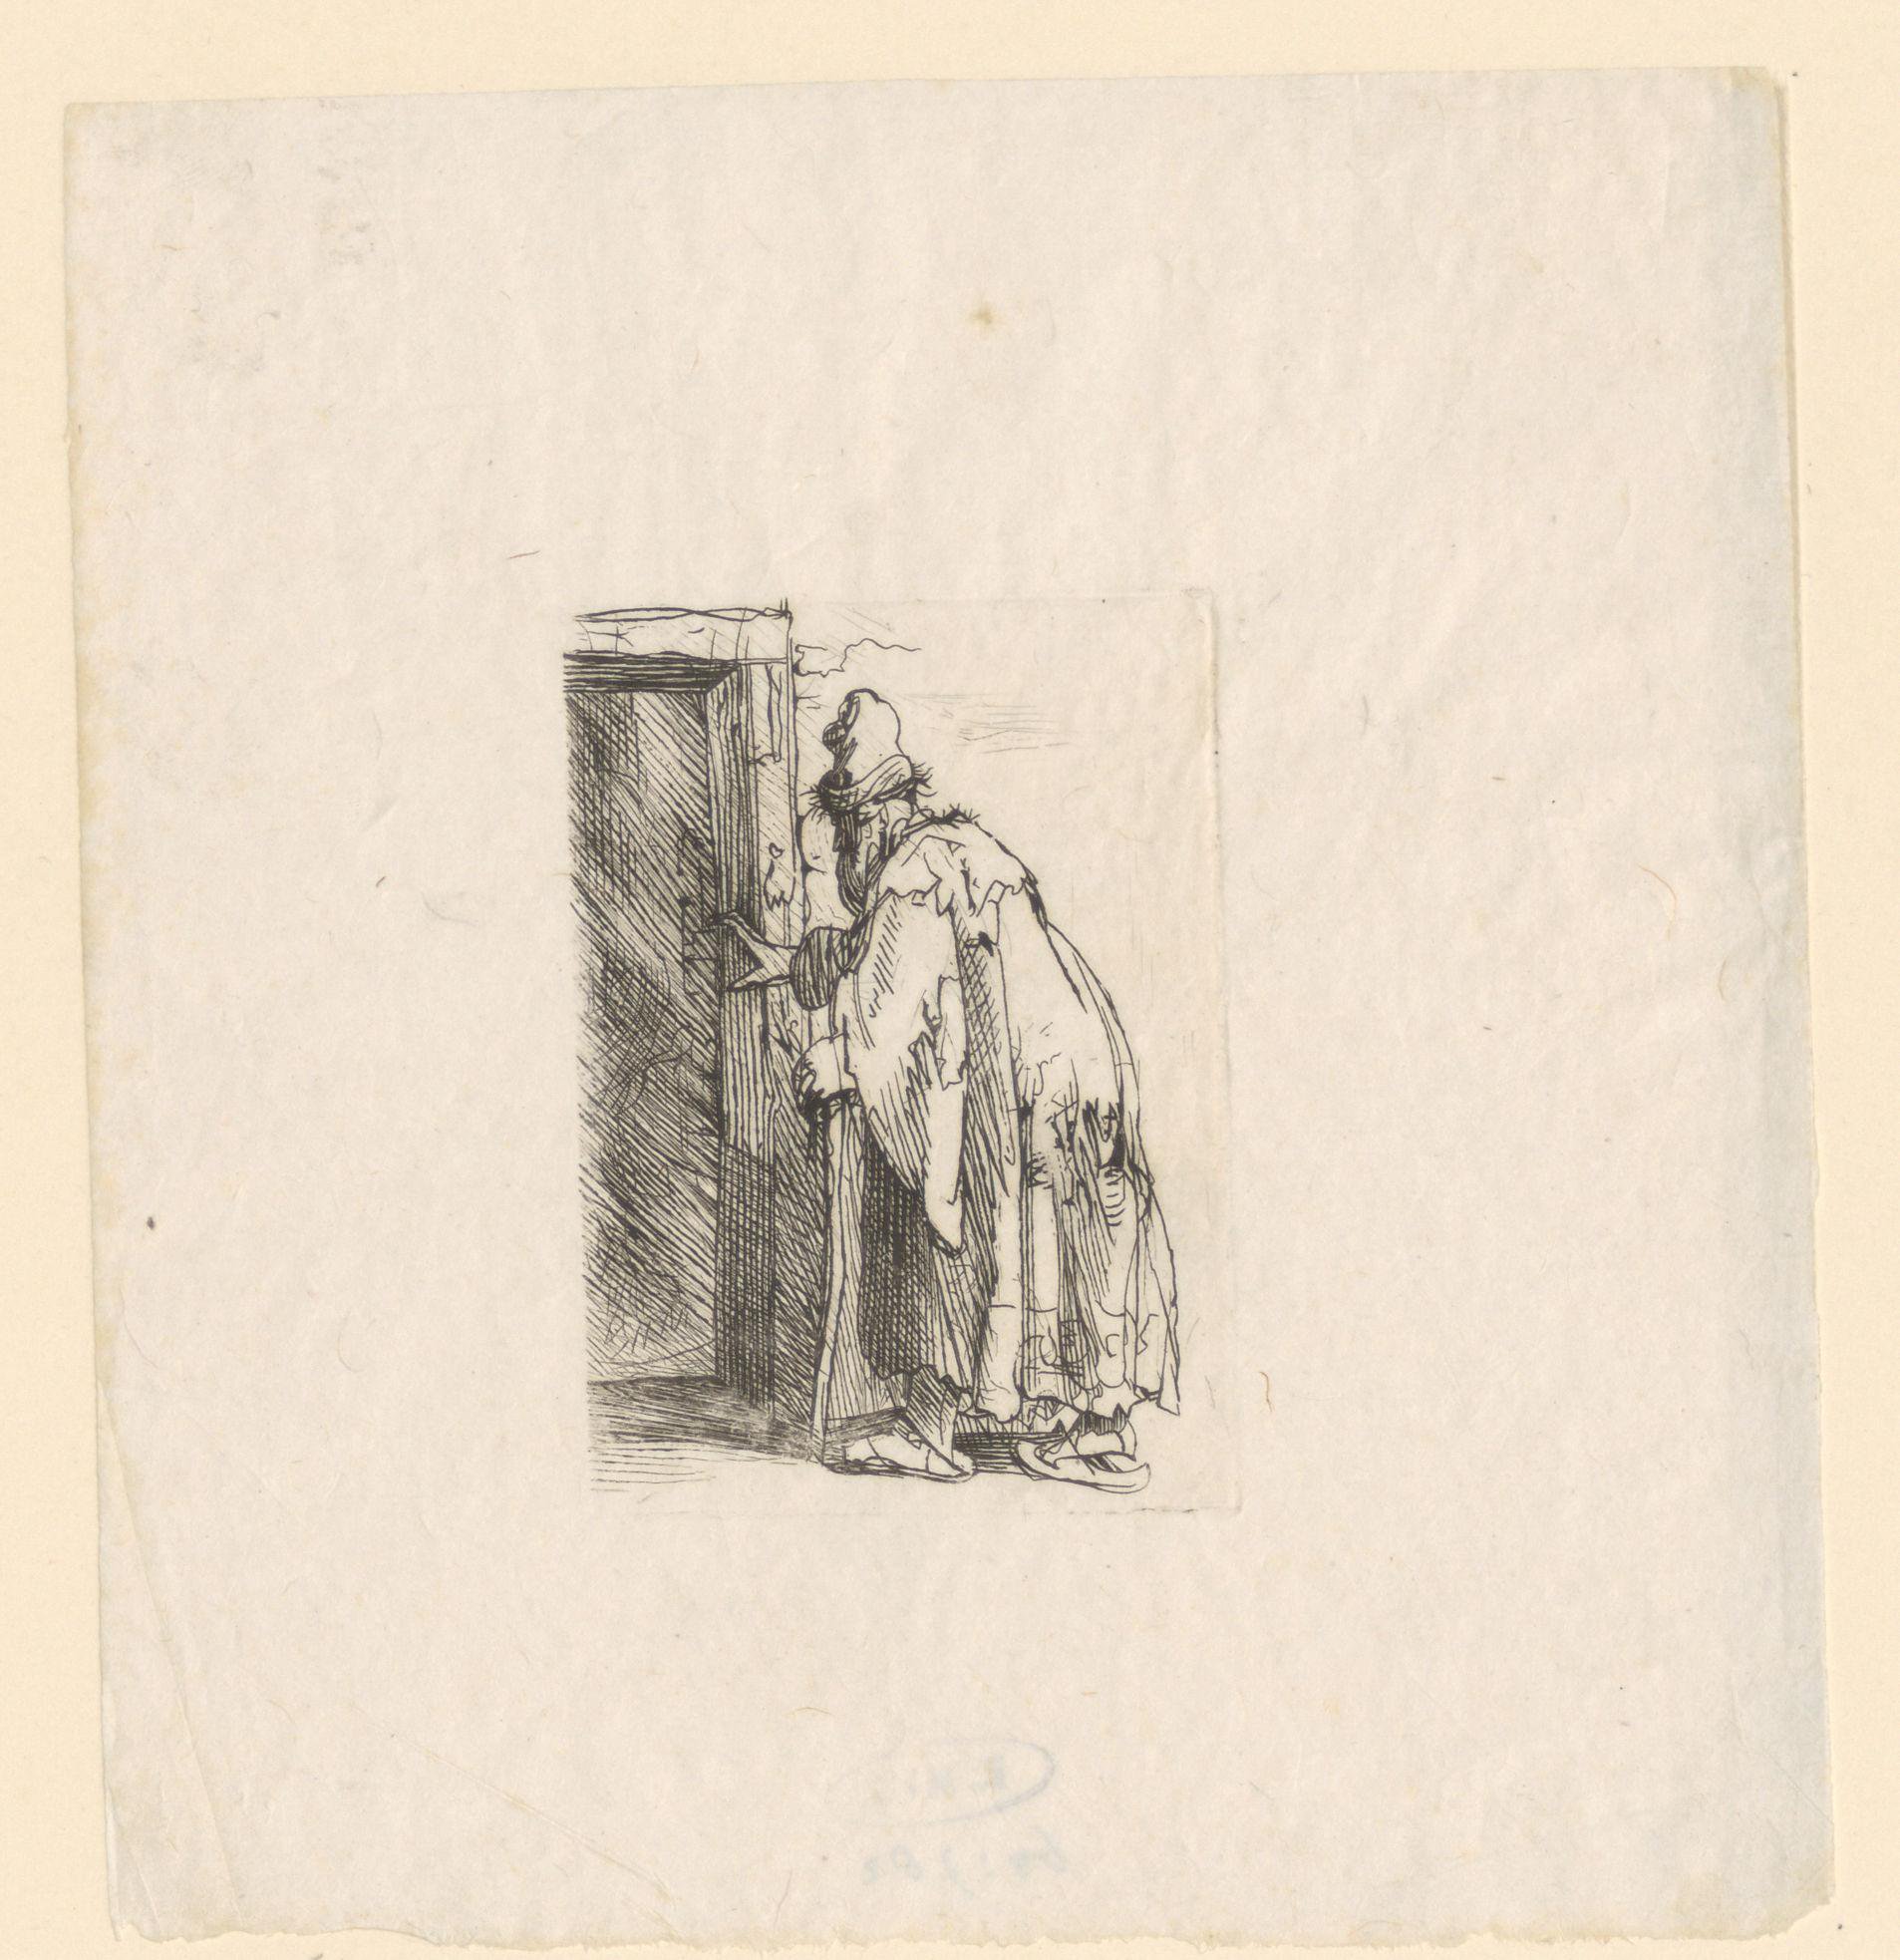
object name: print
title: Blinde Tobias bij een deur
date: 1824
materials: paper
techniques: etching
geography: london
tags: tobit's blindness (tobit 2 - 3:6)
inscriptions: collector's mark: Lugt 2228